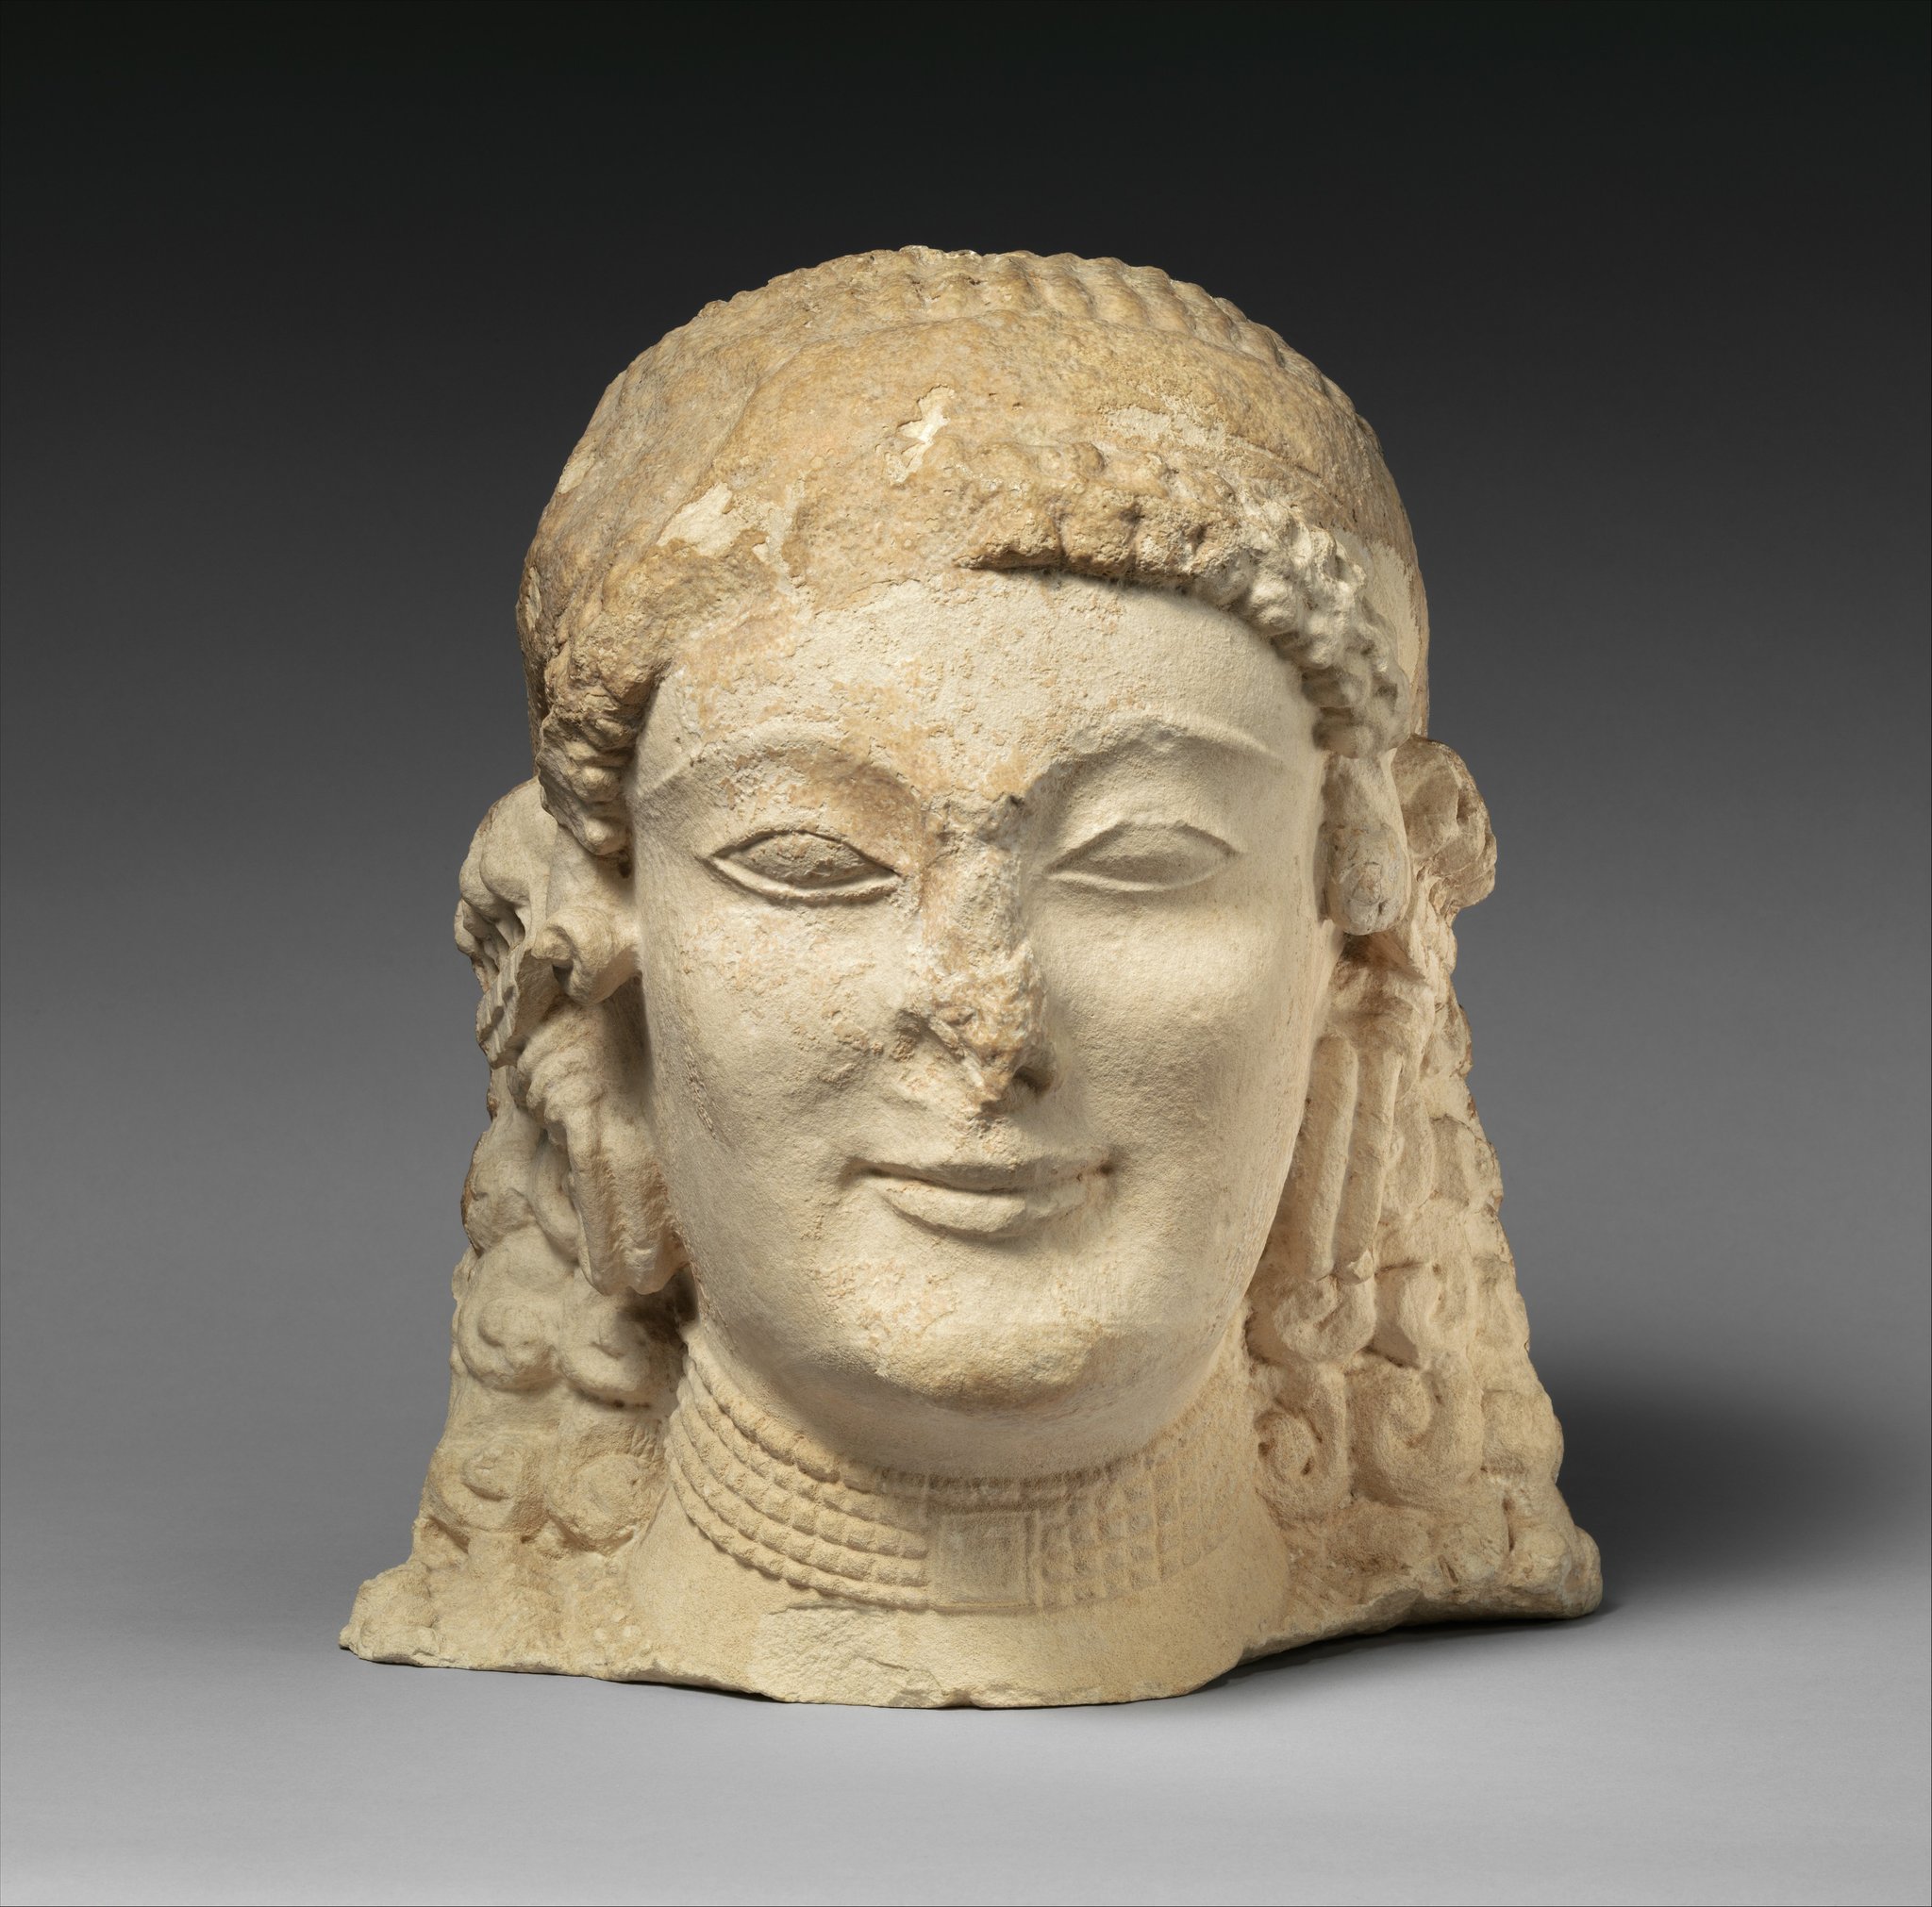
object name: head, female with elaborate jewelry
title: Limestone female head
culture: cypriot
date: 534-468 BCE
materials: limestone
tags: heads,women